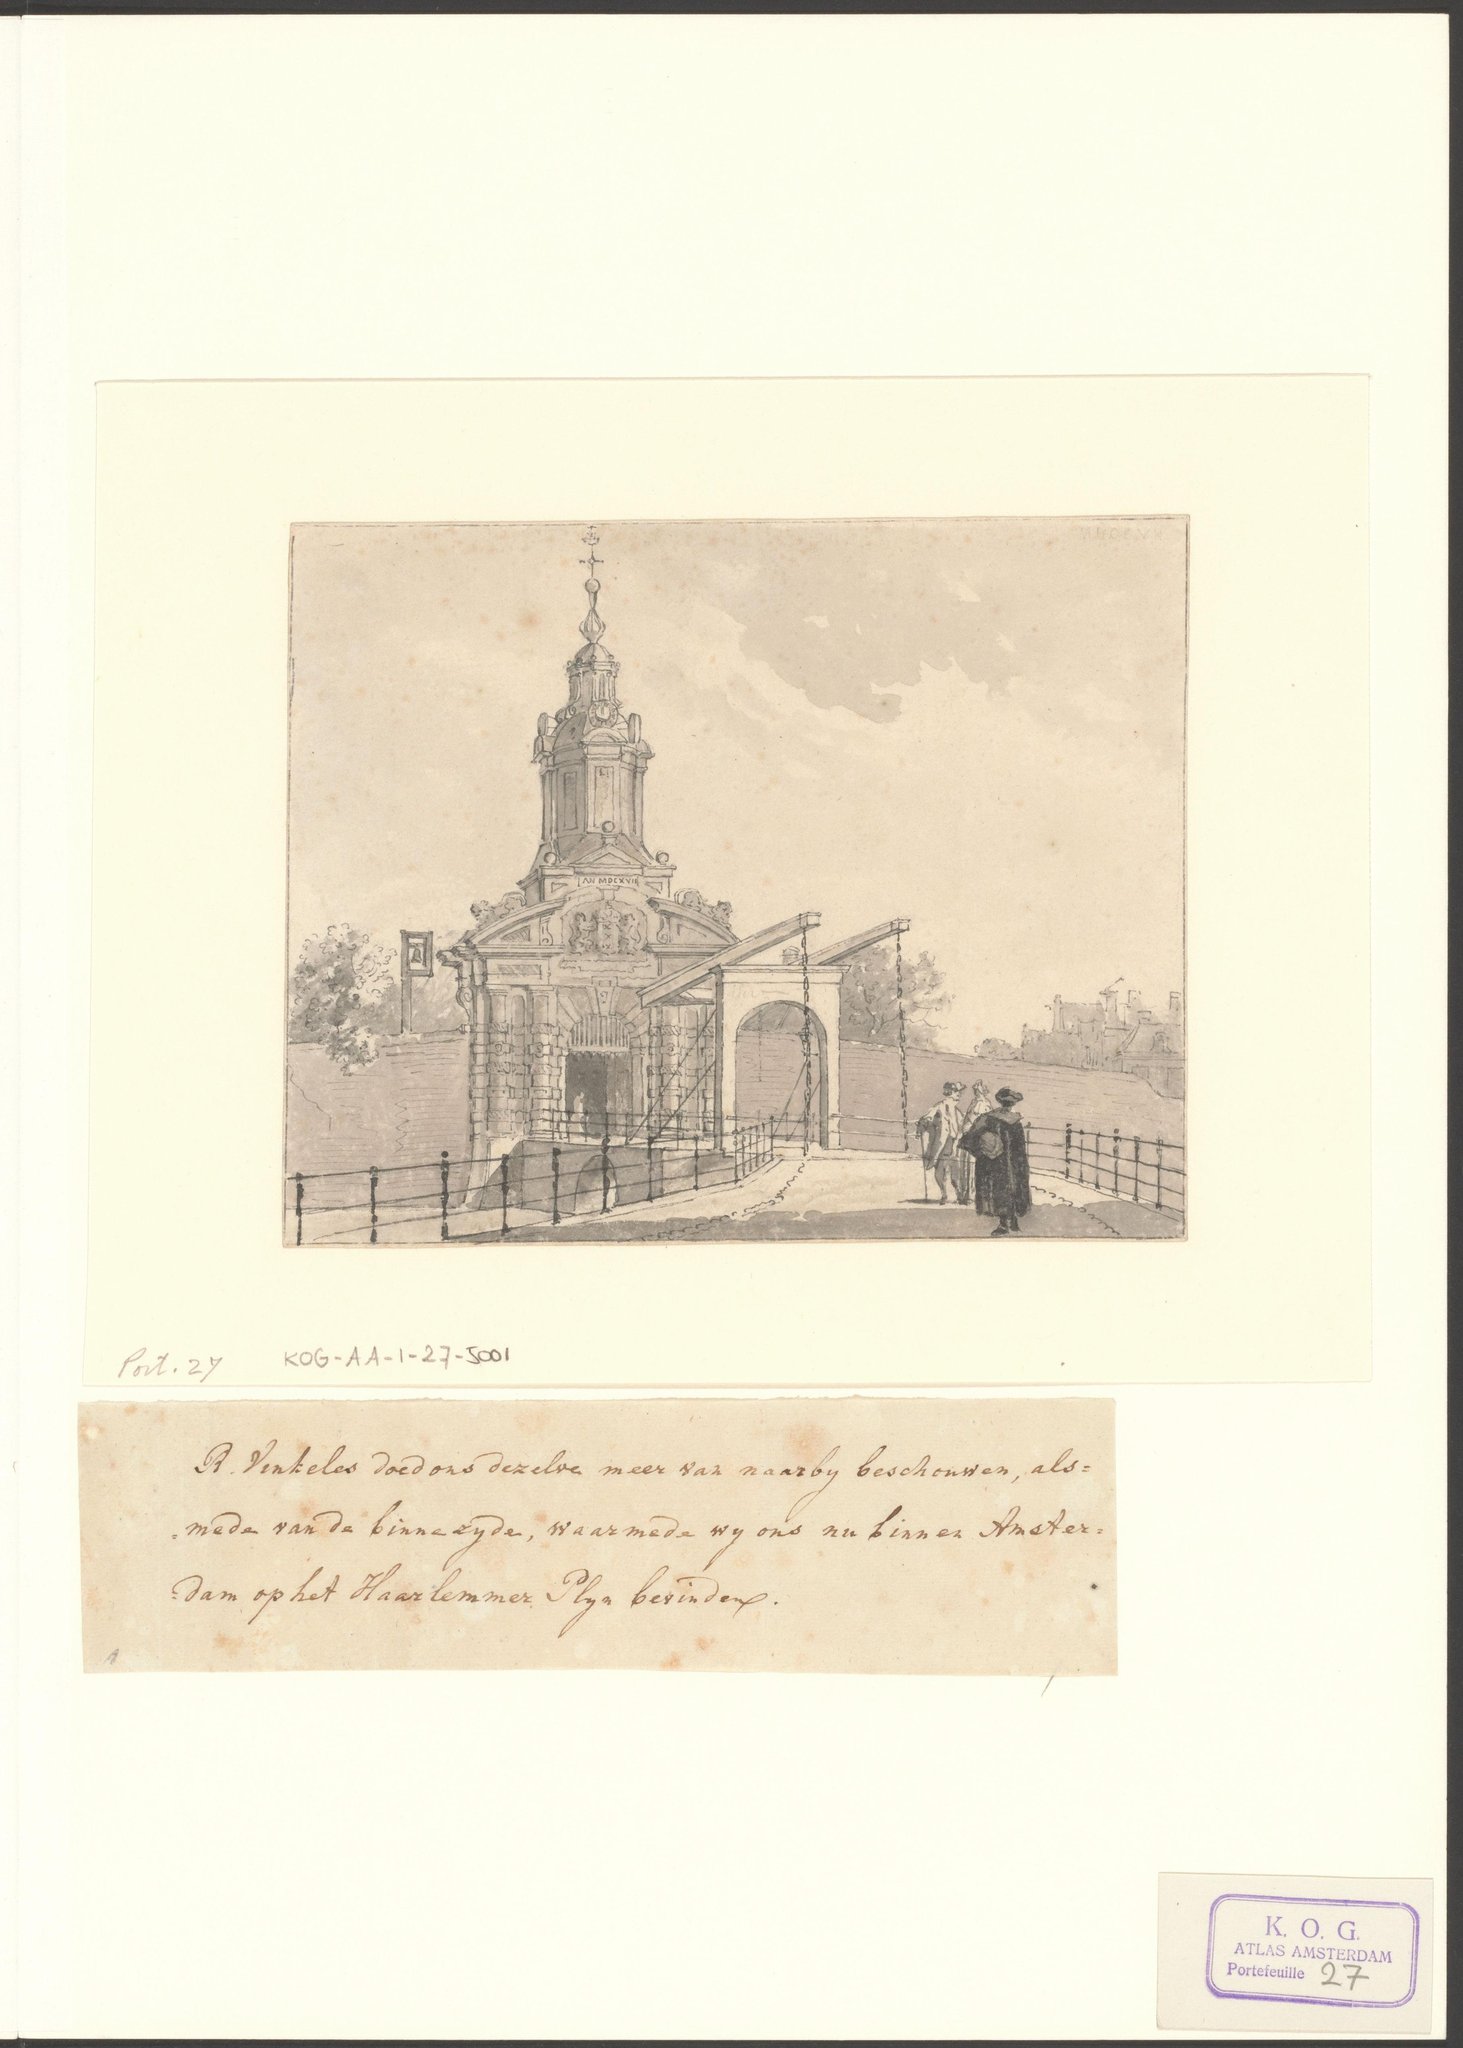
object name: drawing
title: Gezicht op de Haarlemmerpoort, gezien vanaf het Singel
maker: reinier vinkeles (i)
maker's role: draughtsman, print maker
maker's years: 1741-1816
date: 1751-1816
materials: ink, paper, pencil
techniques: brush, pen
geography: amsterdam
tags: city-view in general; 'veduta', canal, bridge in city across river, canal, etc., city-gate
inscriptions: inscription: ‘Port. 27’, collector's mark: ‘27’ Lugt 1641b, inscription: ‘Haarlemmer Poort van buyte te zien R Vinkeles’, inscription: ‘R. Vinkeles doed (...) Haarlemmer Plyn bevinden.’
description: Onderwerpsrubriek binnen de Atlas Amsterdam: Haarlemmerpoort(en).